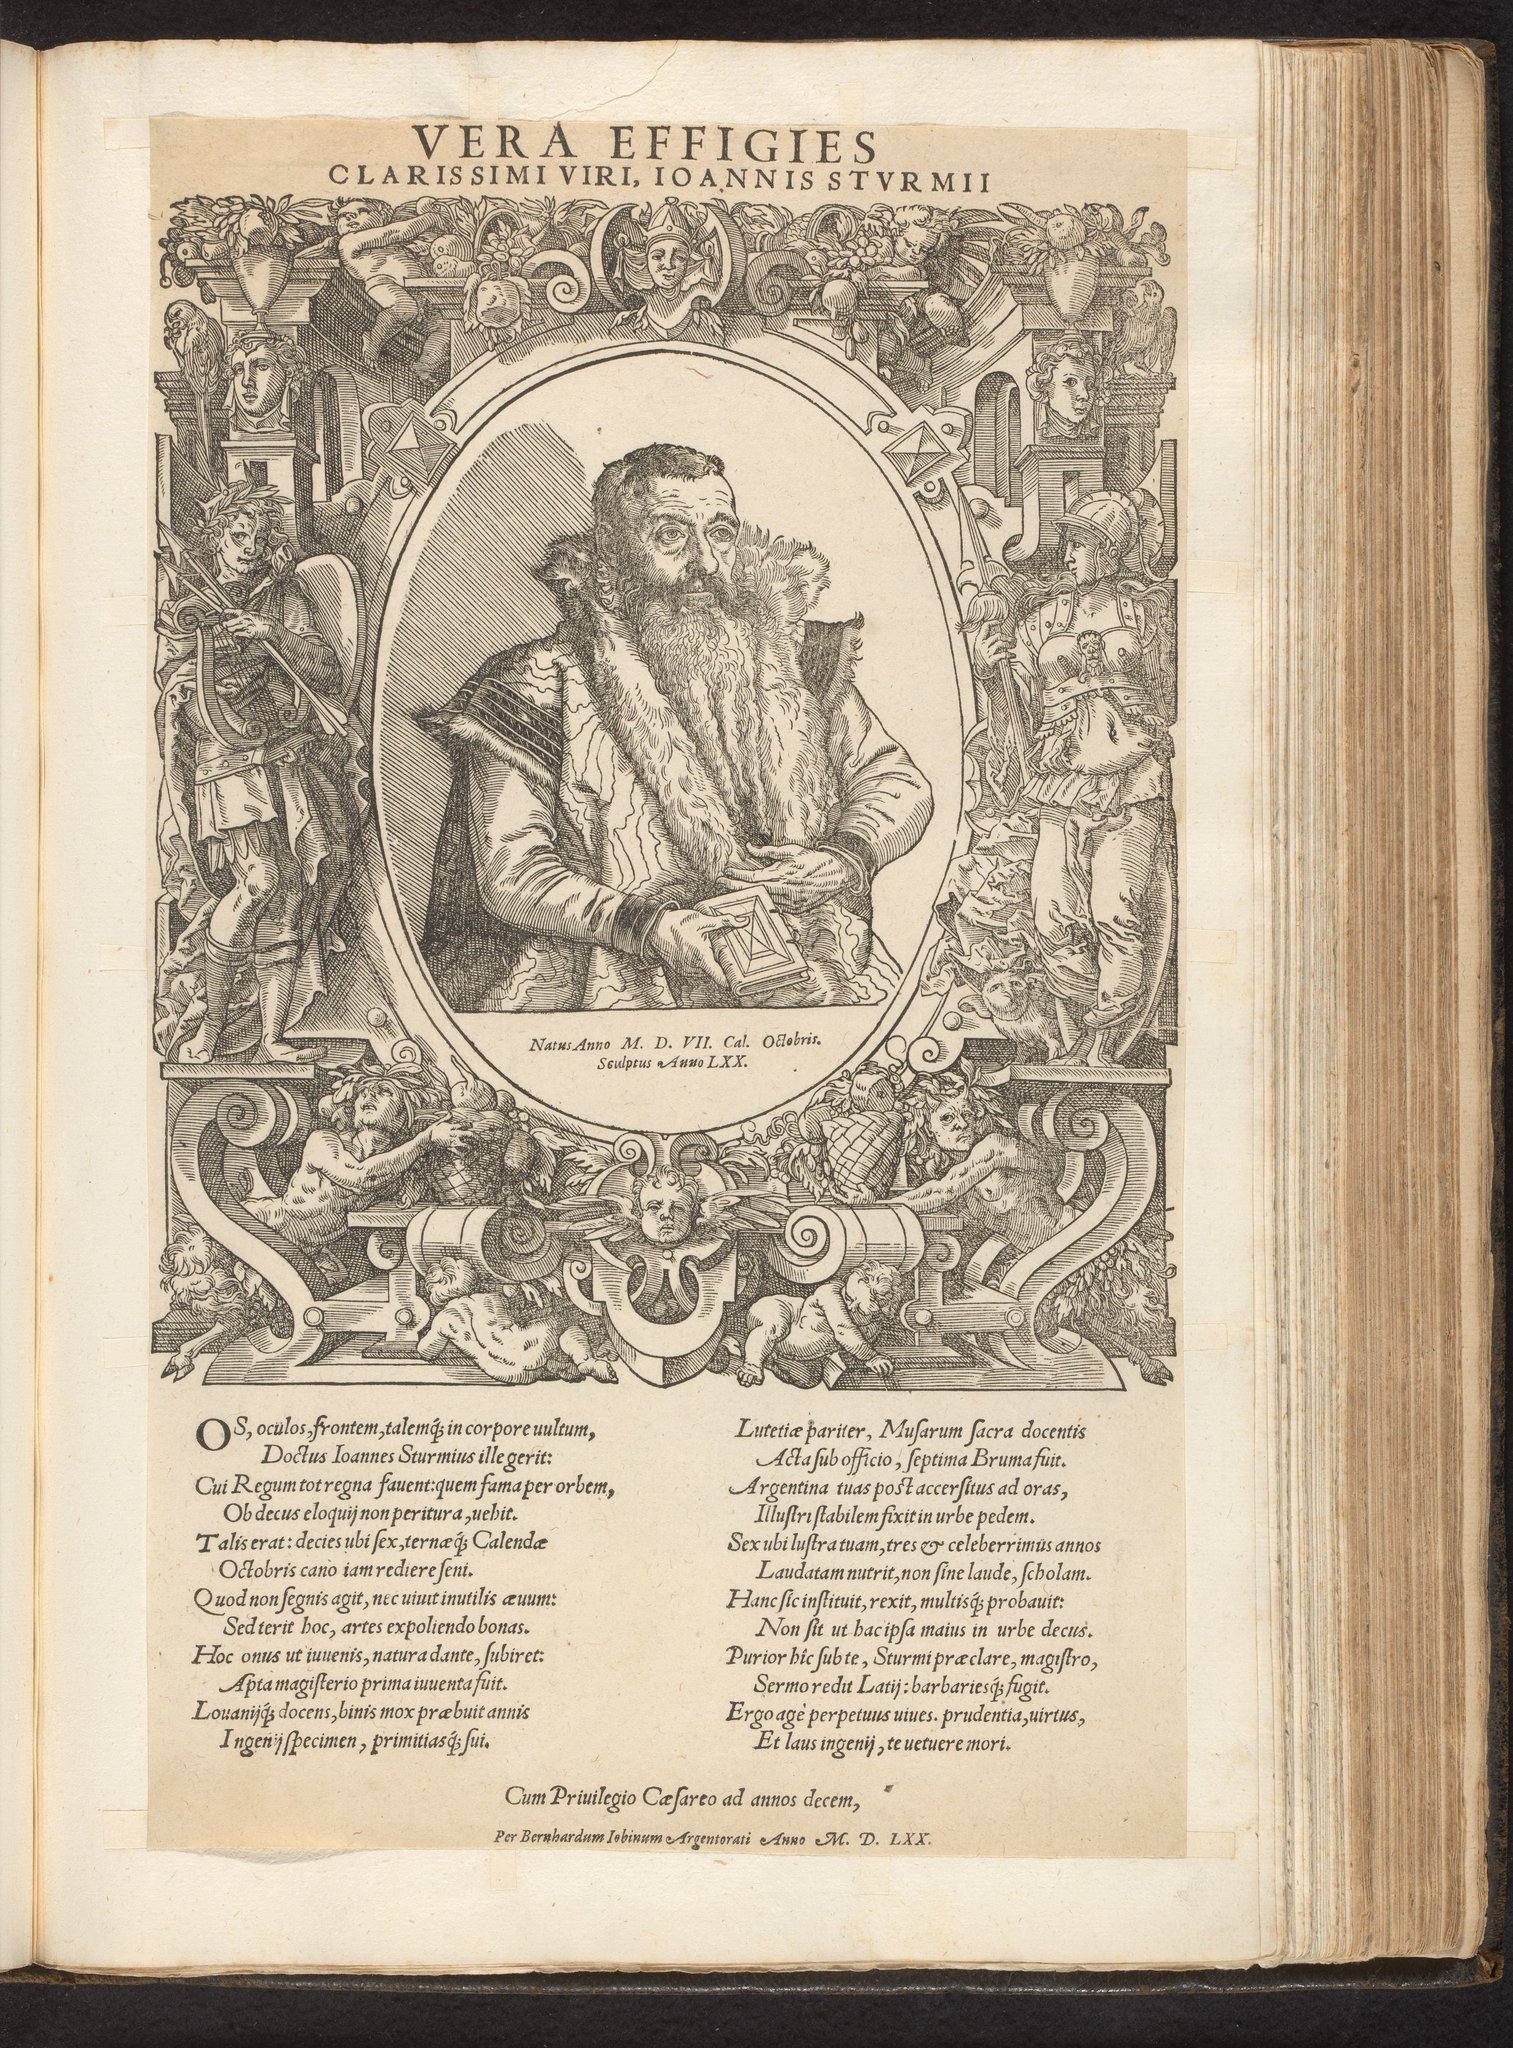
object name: print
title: Portret van Johann Sturm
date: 1570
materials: paper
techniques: letterpress printing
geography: straatsburg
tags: historical persons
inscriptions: date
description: Twee personificaties in de rijkversierde omlijsting. Tekst in het Latijn in de boven- en ondermarge. Prent maakt deel uit van een album.